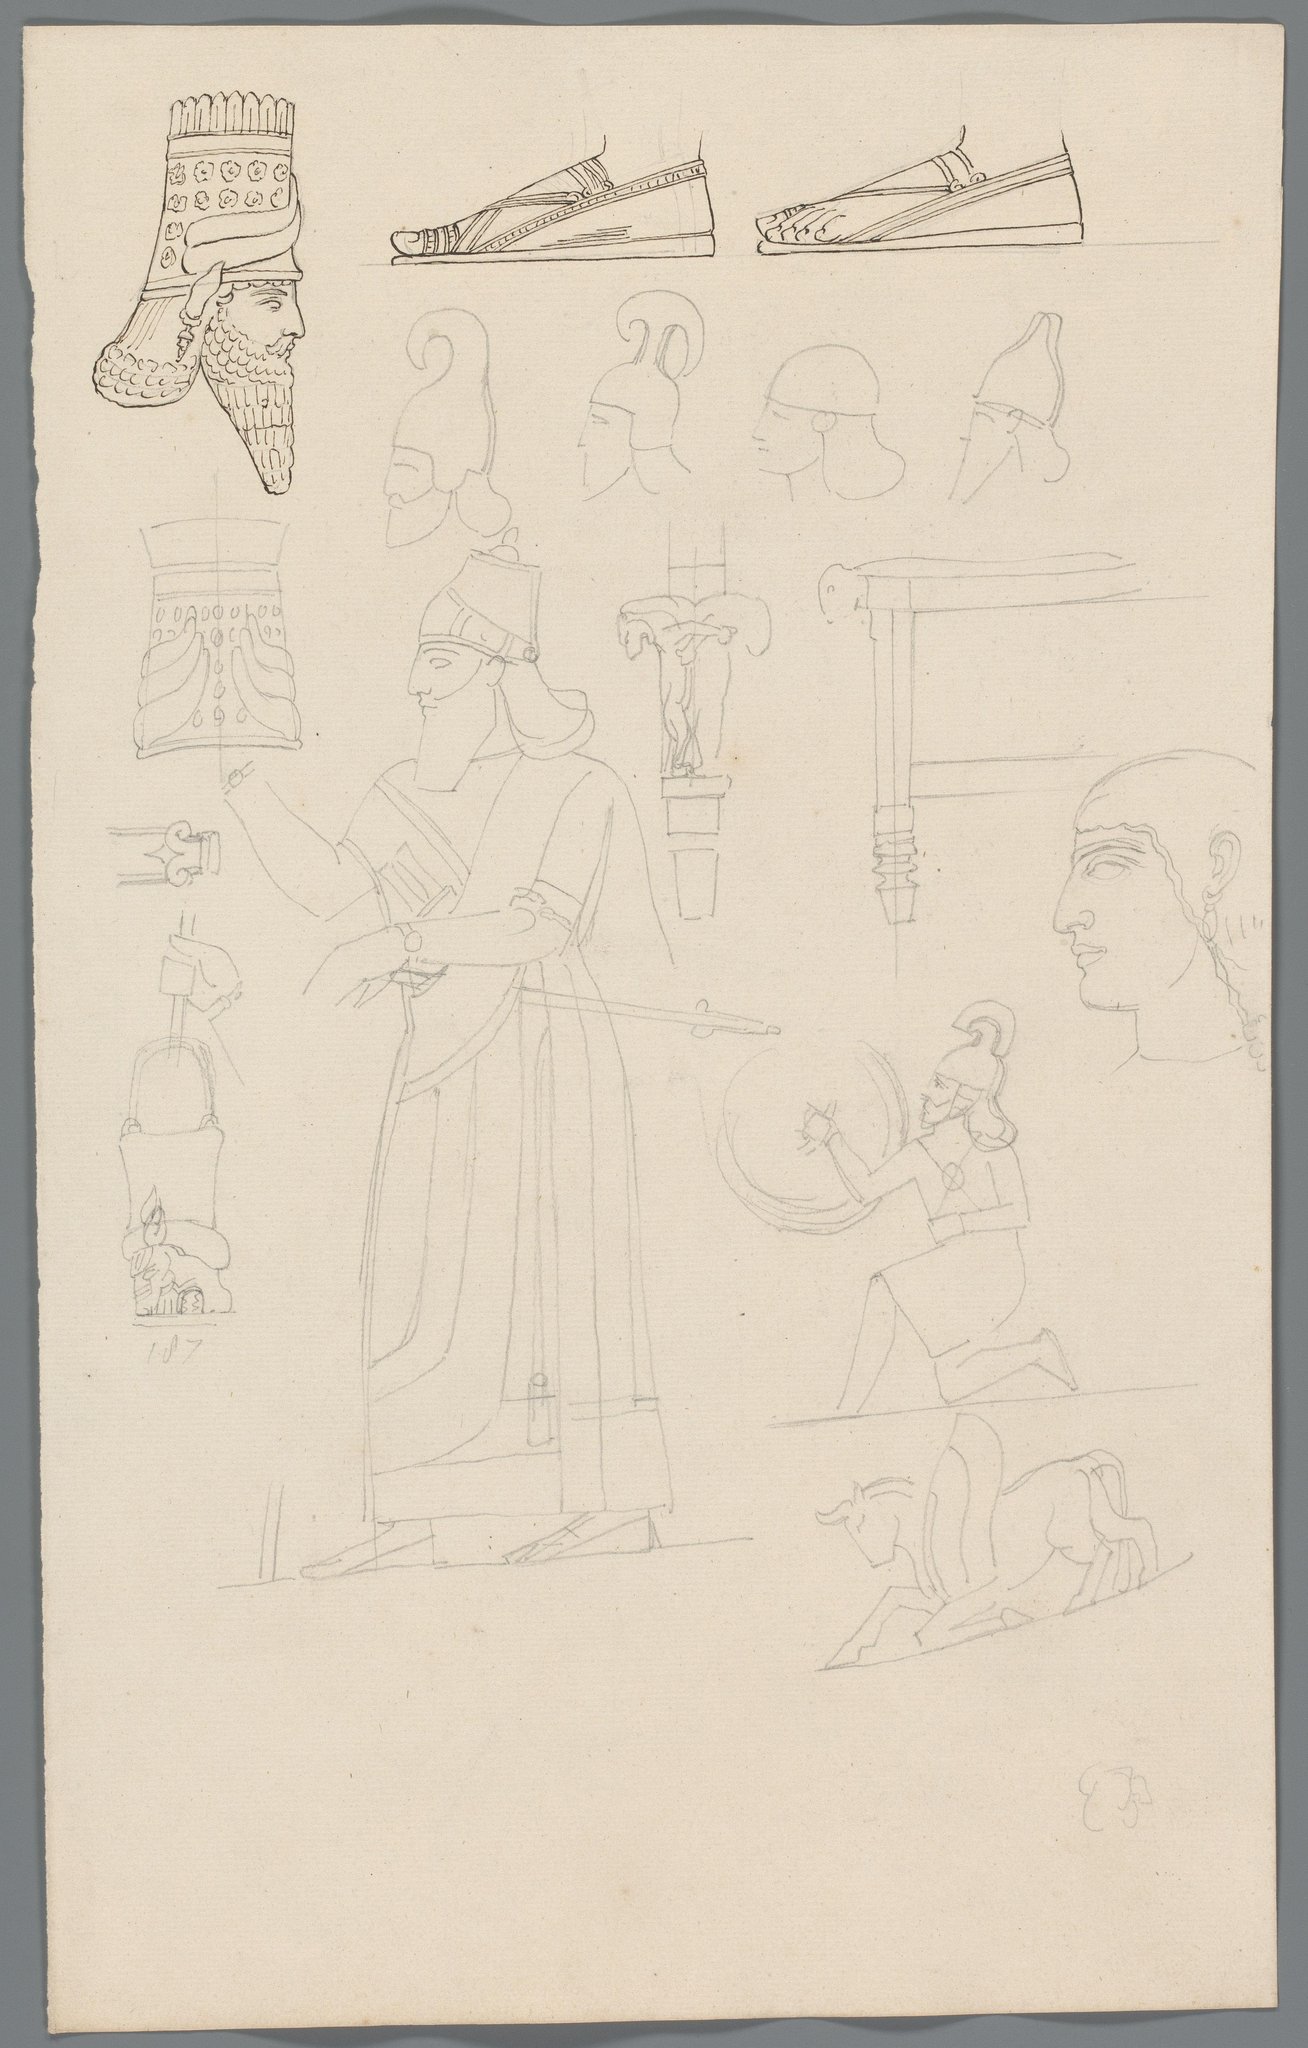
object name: drawing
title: Voorbeelden van Assyrische kunst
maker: jacobus everhardus josephus van den berg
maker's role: draughtsman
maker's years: 1802-1861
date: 1812-1861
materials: ink, paper, pencil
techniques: pen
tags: head-gear, art, foot